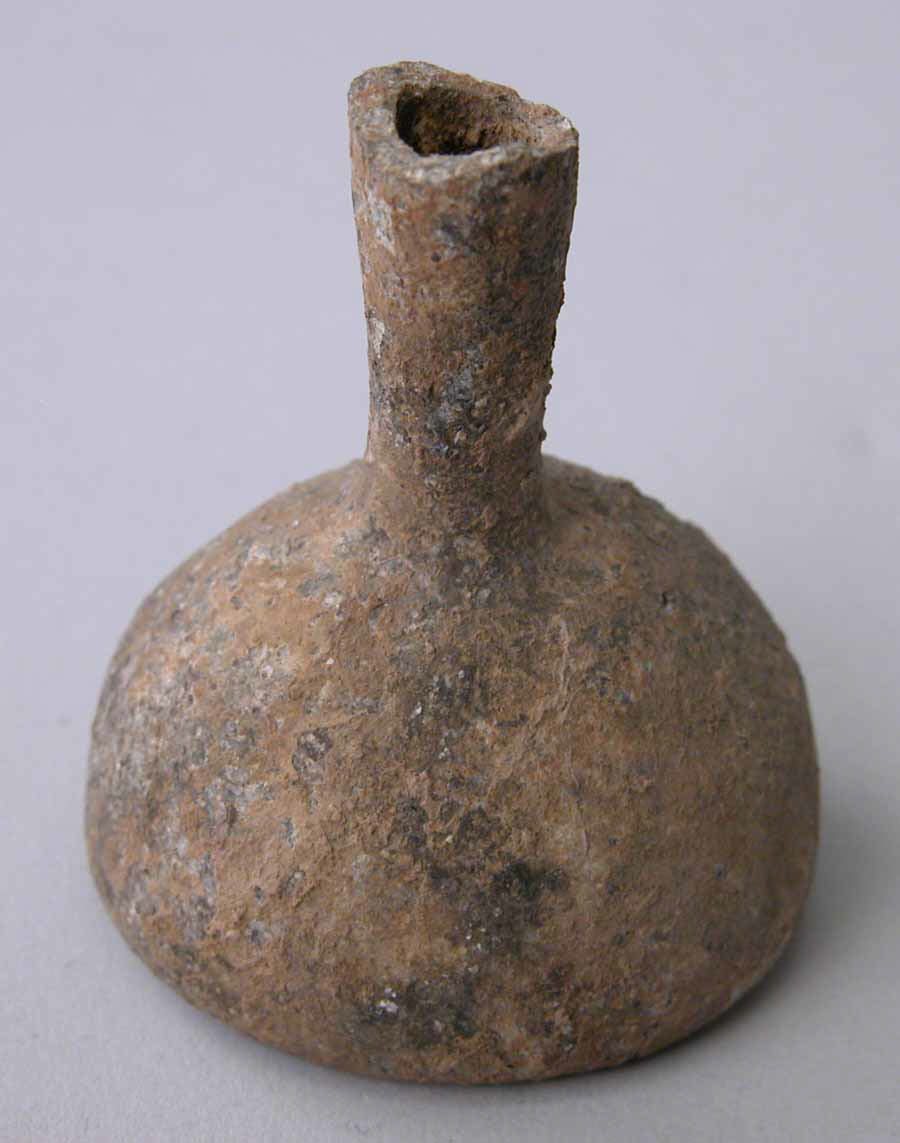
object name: bottle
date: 601-800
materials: glass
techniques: glassblowing, tooling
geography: iraq